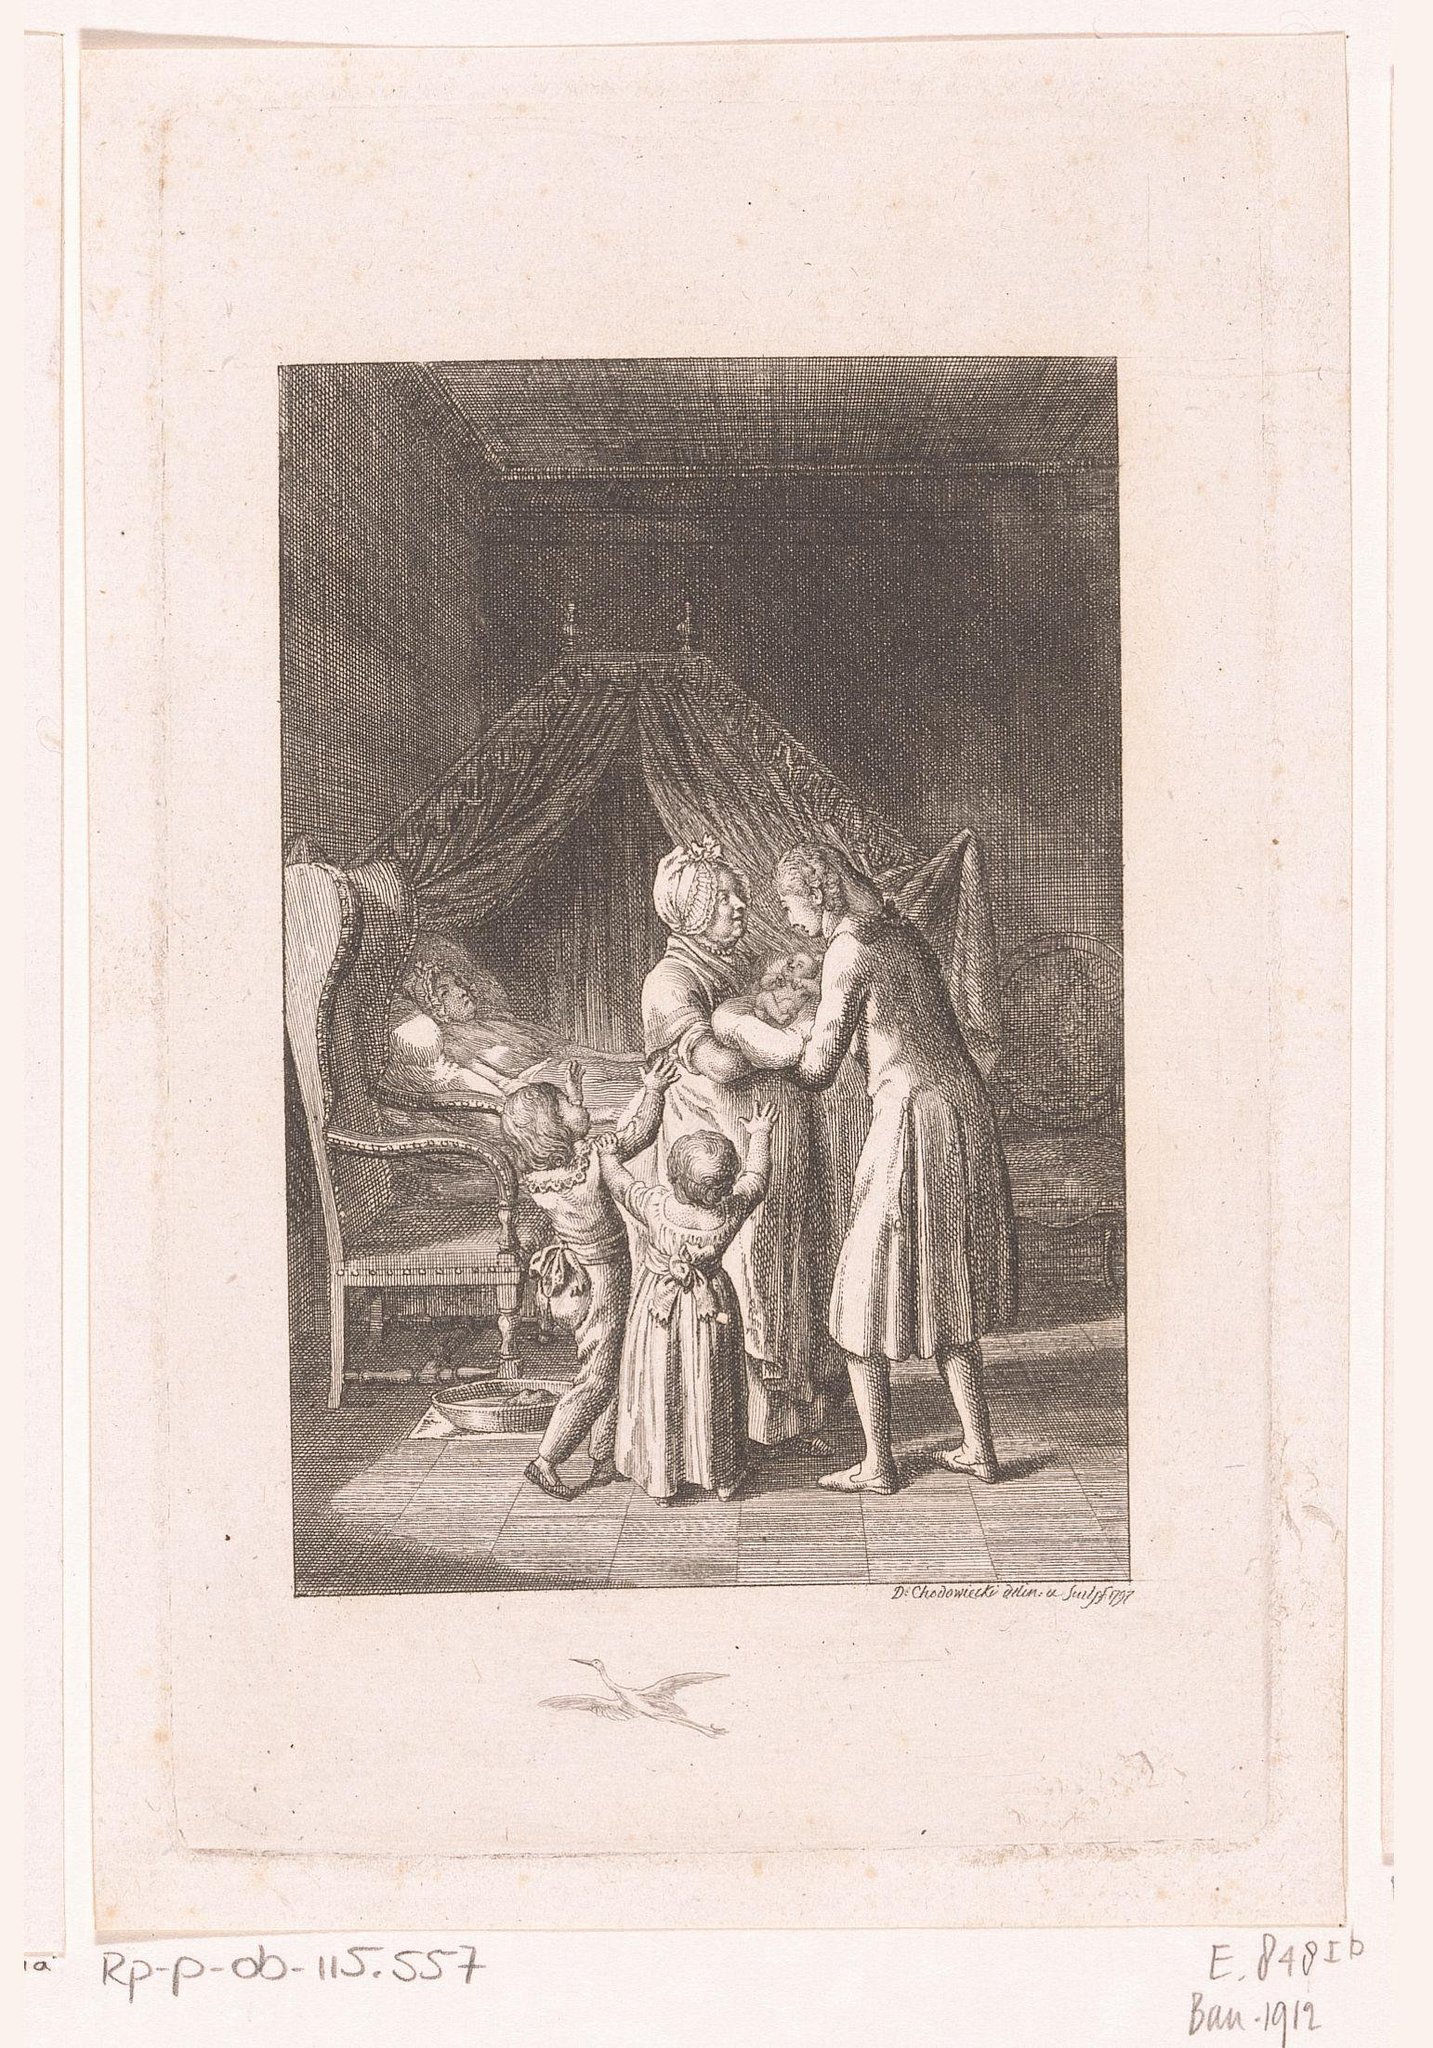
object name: print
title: Vader krijgt zijn nieuwgeboren kind in de armen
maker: daniel nikolaus chodowiecki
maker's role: draughtsman, print maker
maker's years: 1726-1801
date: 1797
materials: paper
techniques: etching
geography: berlin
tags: the new-born child shown to the father, lying-in room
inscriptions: collector's mark: Lugt 2228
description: Latere staat gebruikt voor: Lang, Karl. Almanach und Taschenbuch für Häusliche und Gesellschaftl. Freuden (...). Heilbronn: Industrie Comtoir, s.a.